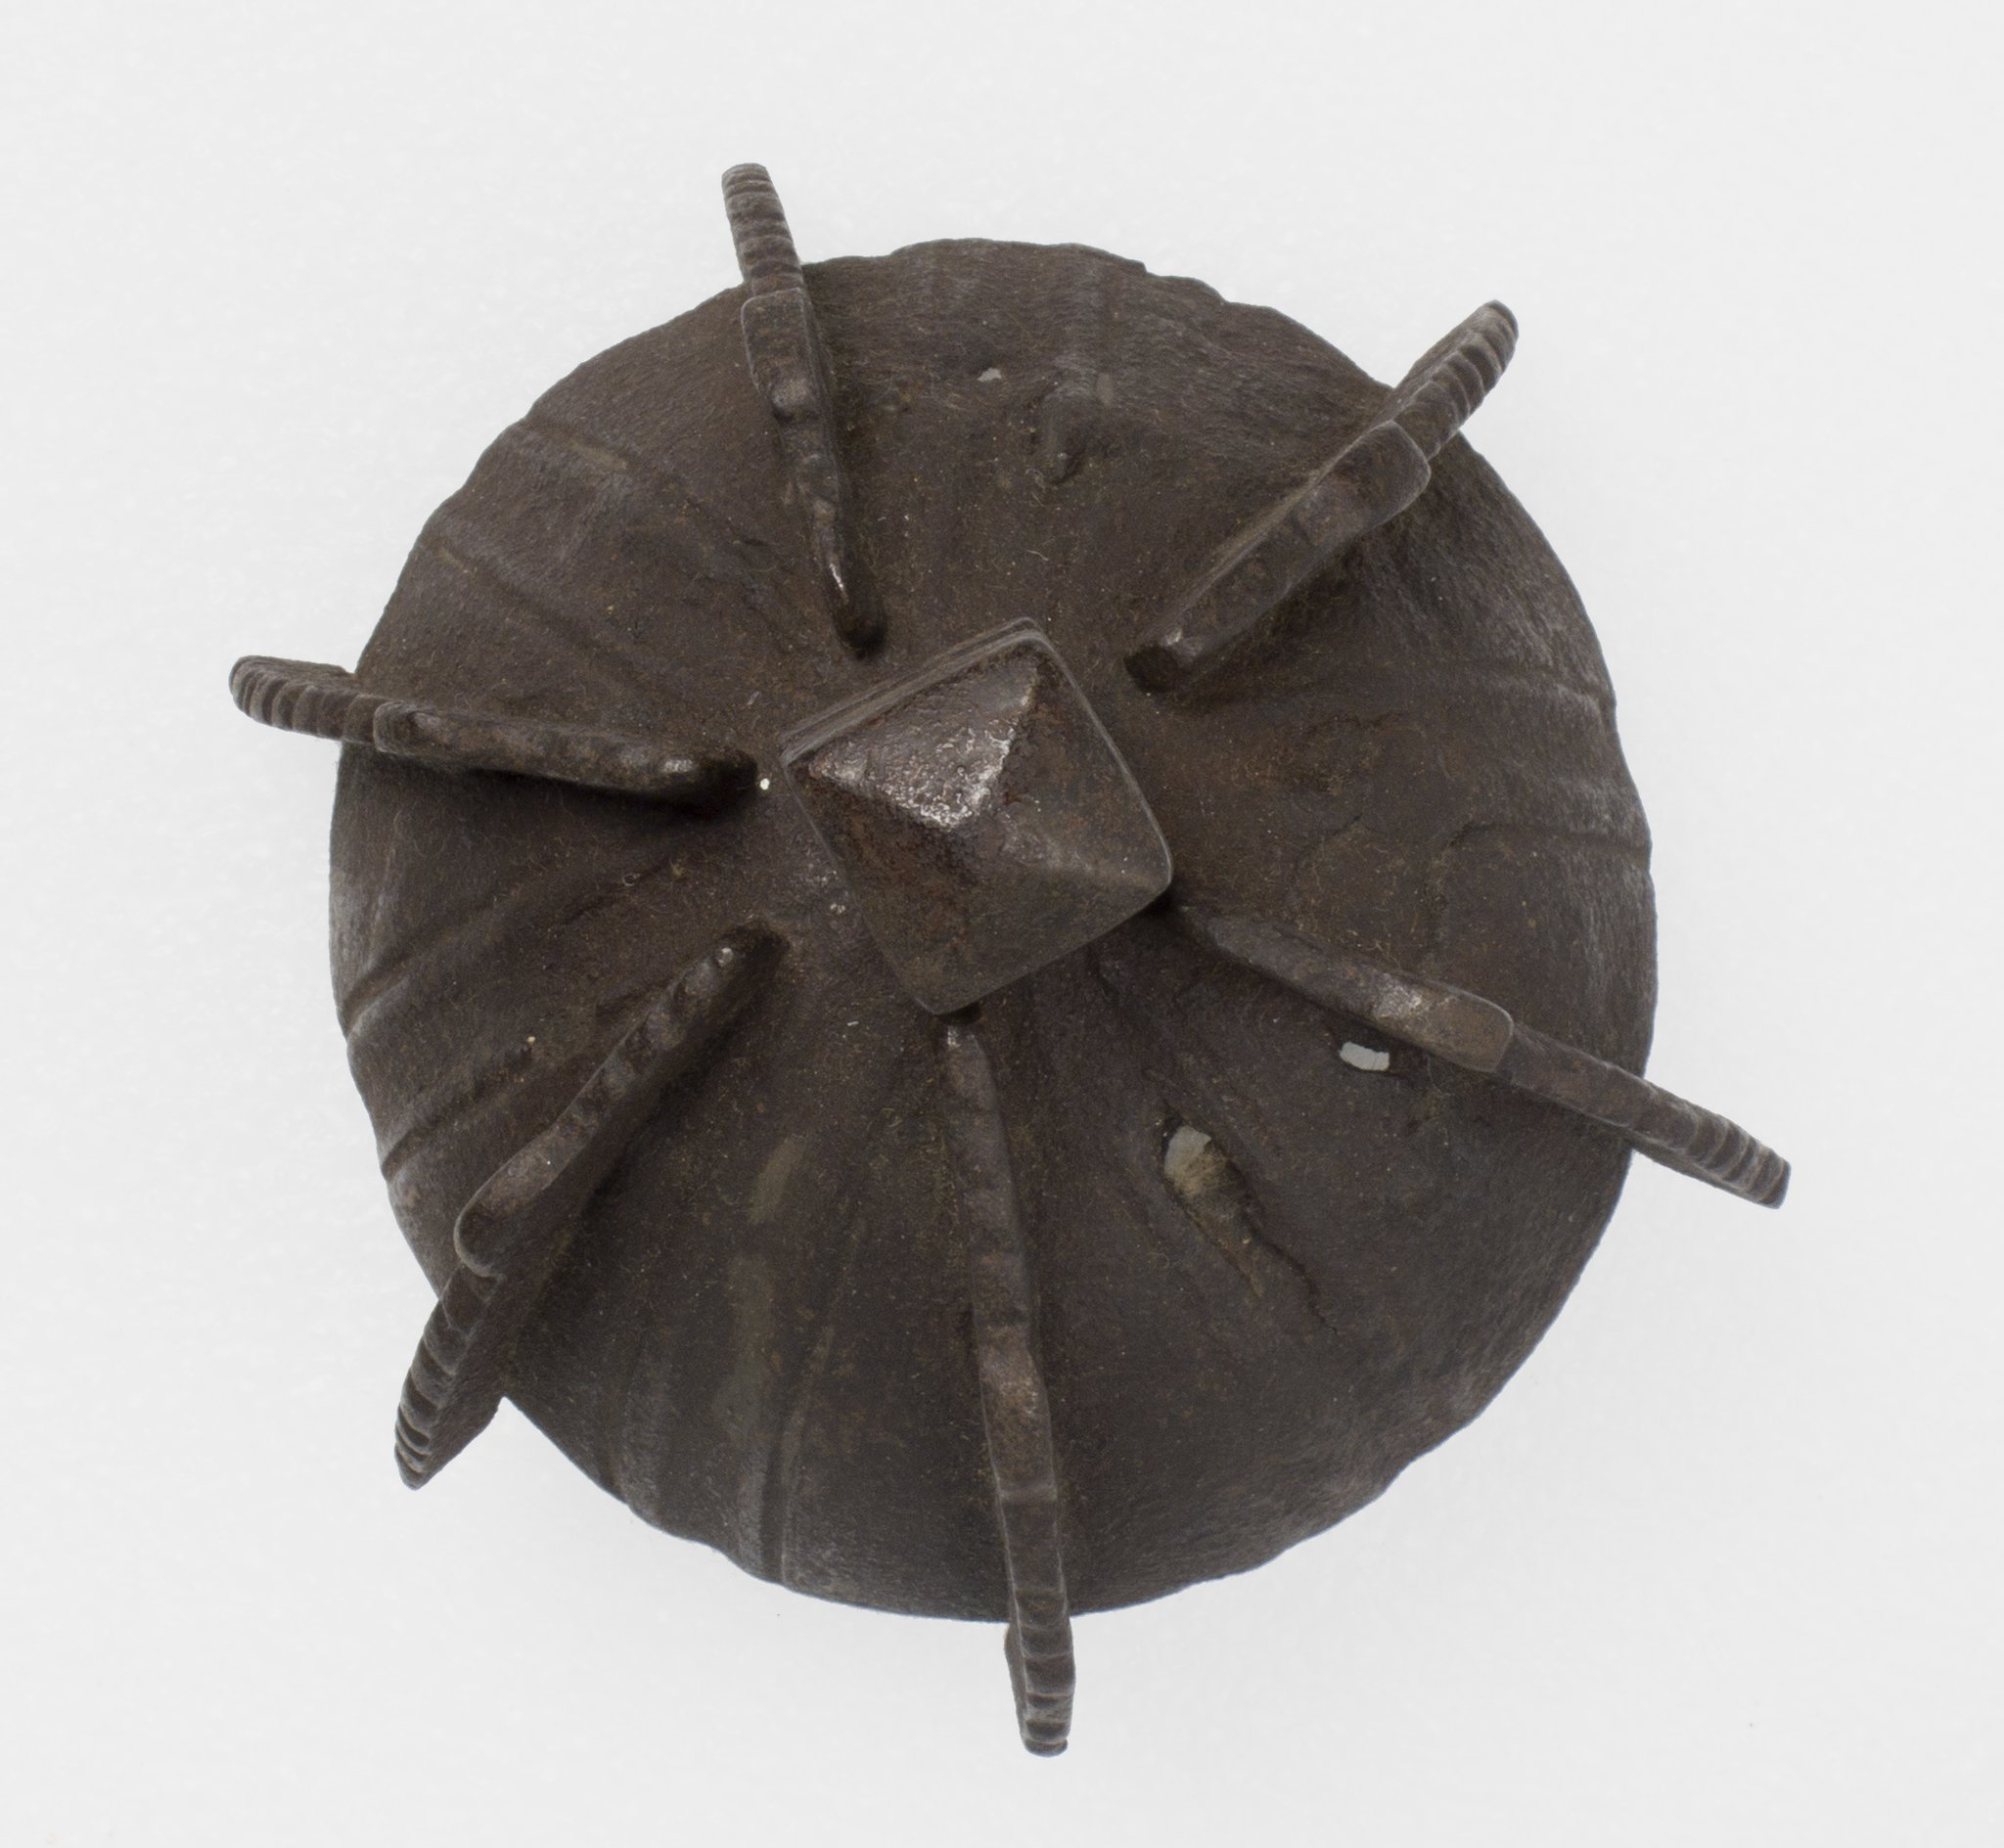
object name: bos and nail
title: Boss and Nail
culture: european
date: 1401-1600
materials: iron